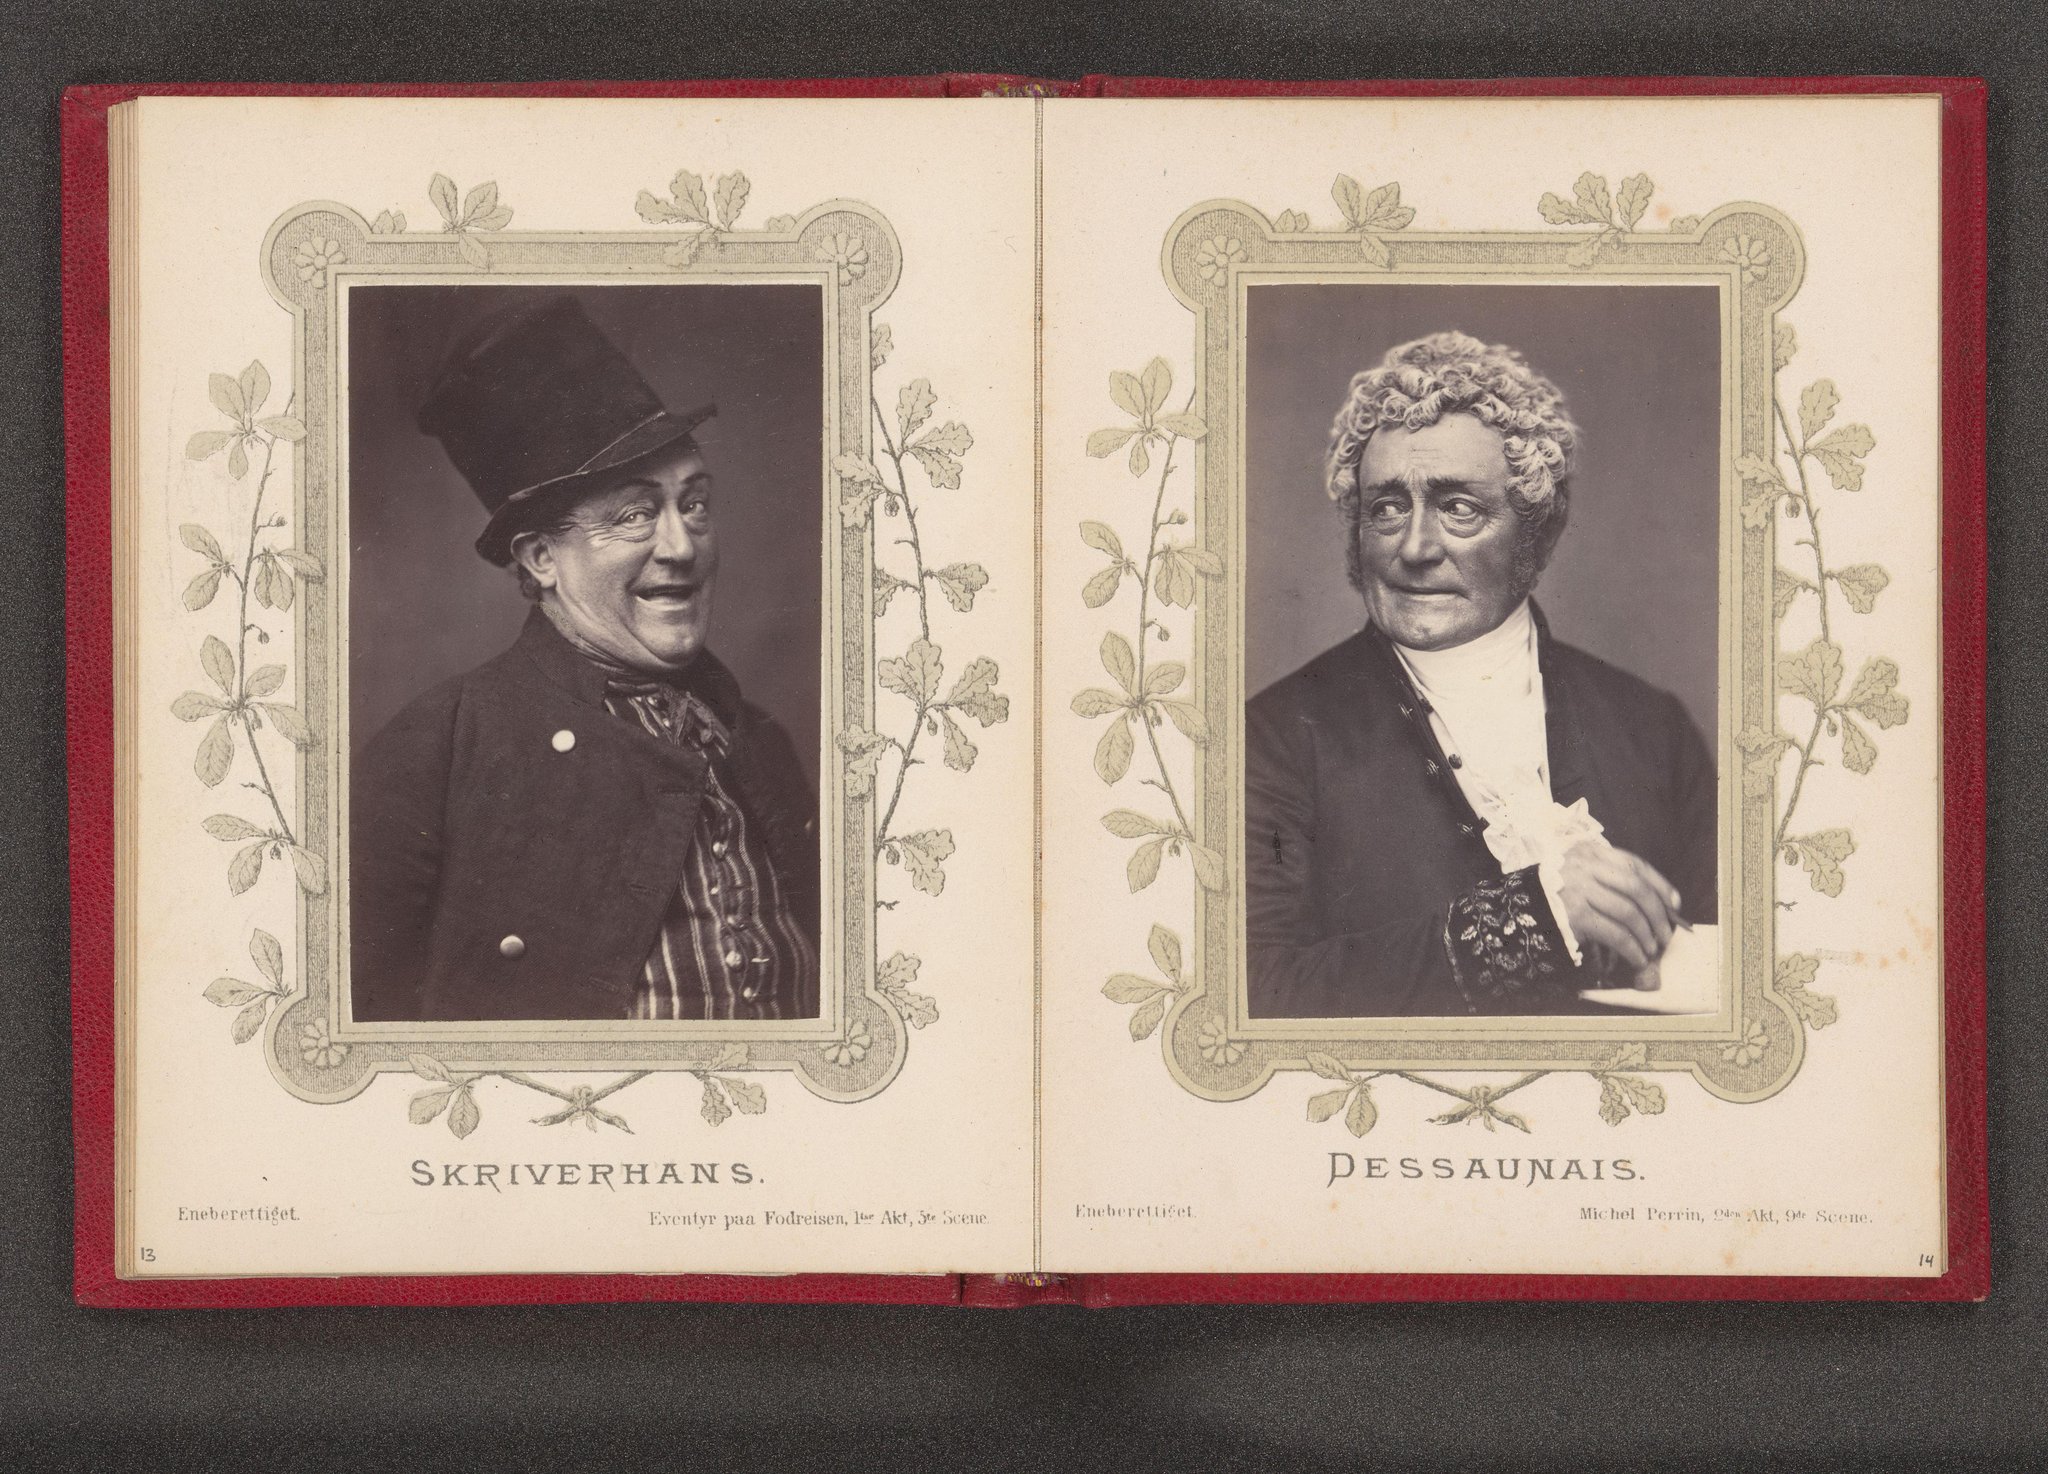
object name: page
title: Dessaunais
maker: harald paetz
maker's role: fotograaf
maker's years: 1837-1895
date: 1862-1872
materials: photographic support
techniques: albumen print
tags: stage costume, portrait of actor, actress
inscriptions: inscription: ‘Eneberettiget Michel Perrin, 2den Akt, 9de Scene.’